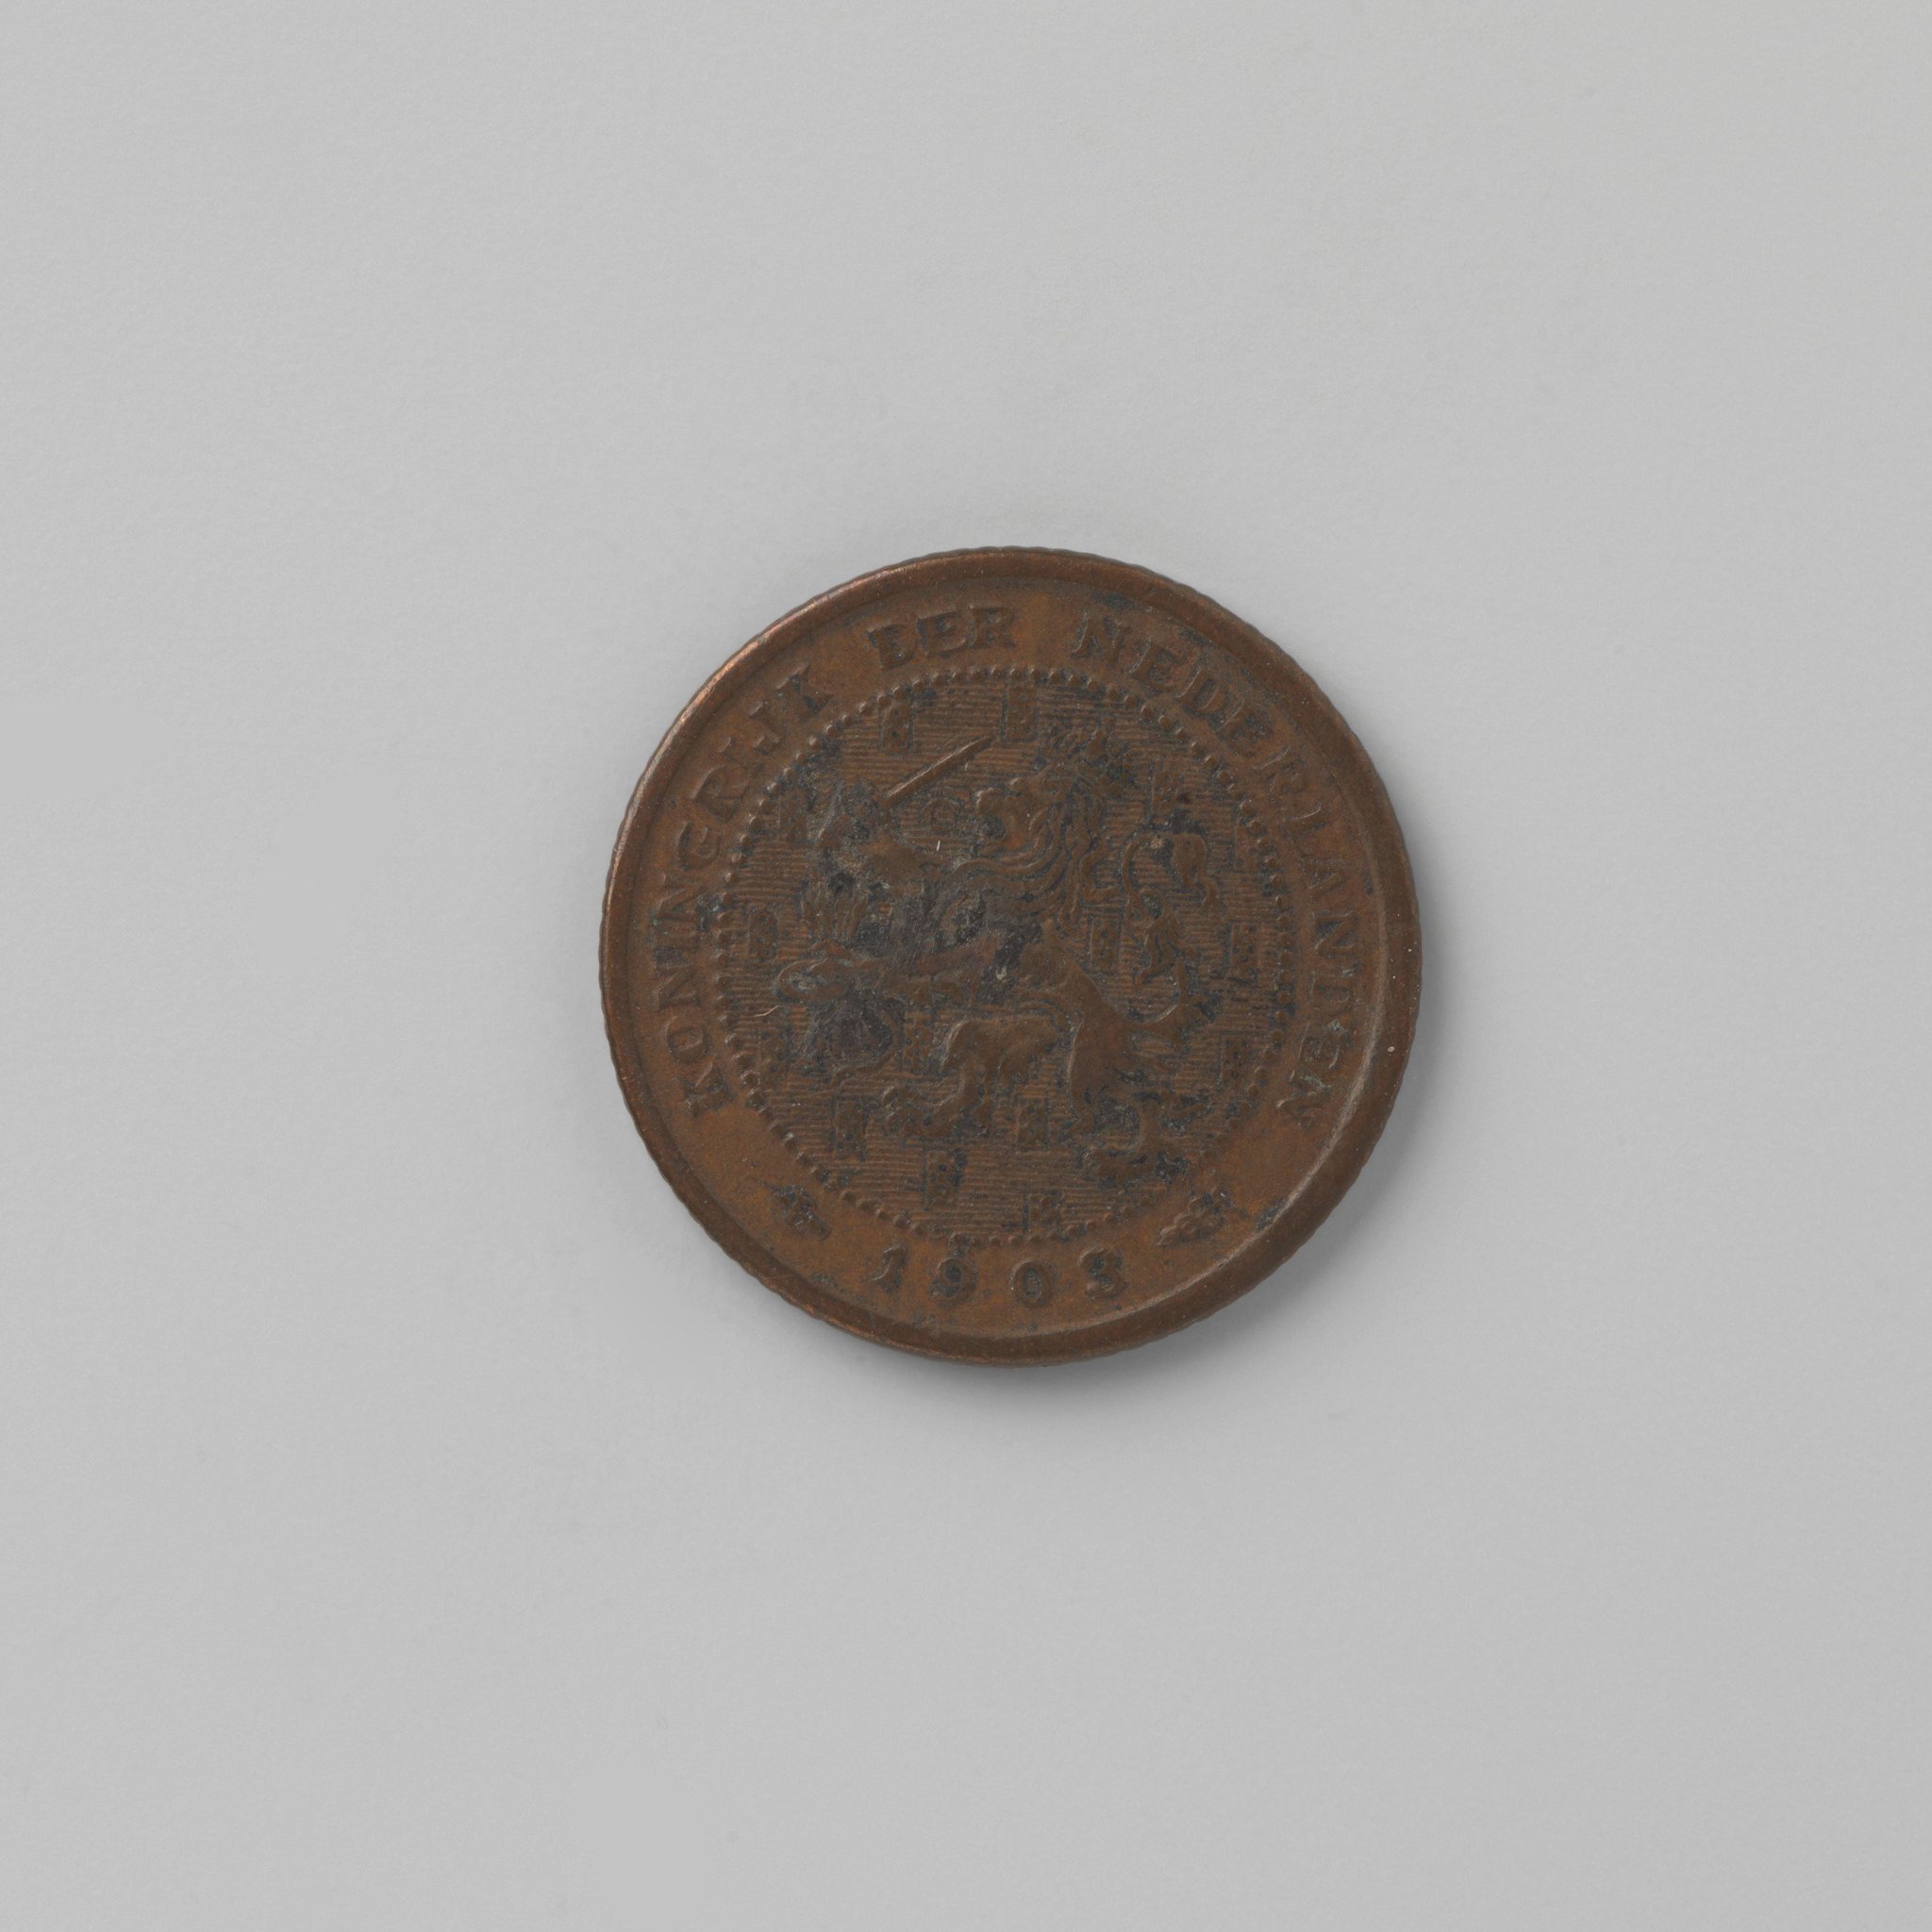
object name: coin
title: Nederlandse ½ cent,1903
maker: wilhelmina of the netherlands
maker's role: print maker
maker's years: 1880-1962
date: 1903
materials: bronze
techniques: striking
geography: utrecht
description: Bronzen munt. Voorzijde: in een veld rijkswapen. Jaartal onderaan in omschrift. Keerzijde: binnen twee samengebonden oranjetakken waarde-aanduiding ½ cent. Kartelrand.